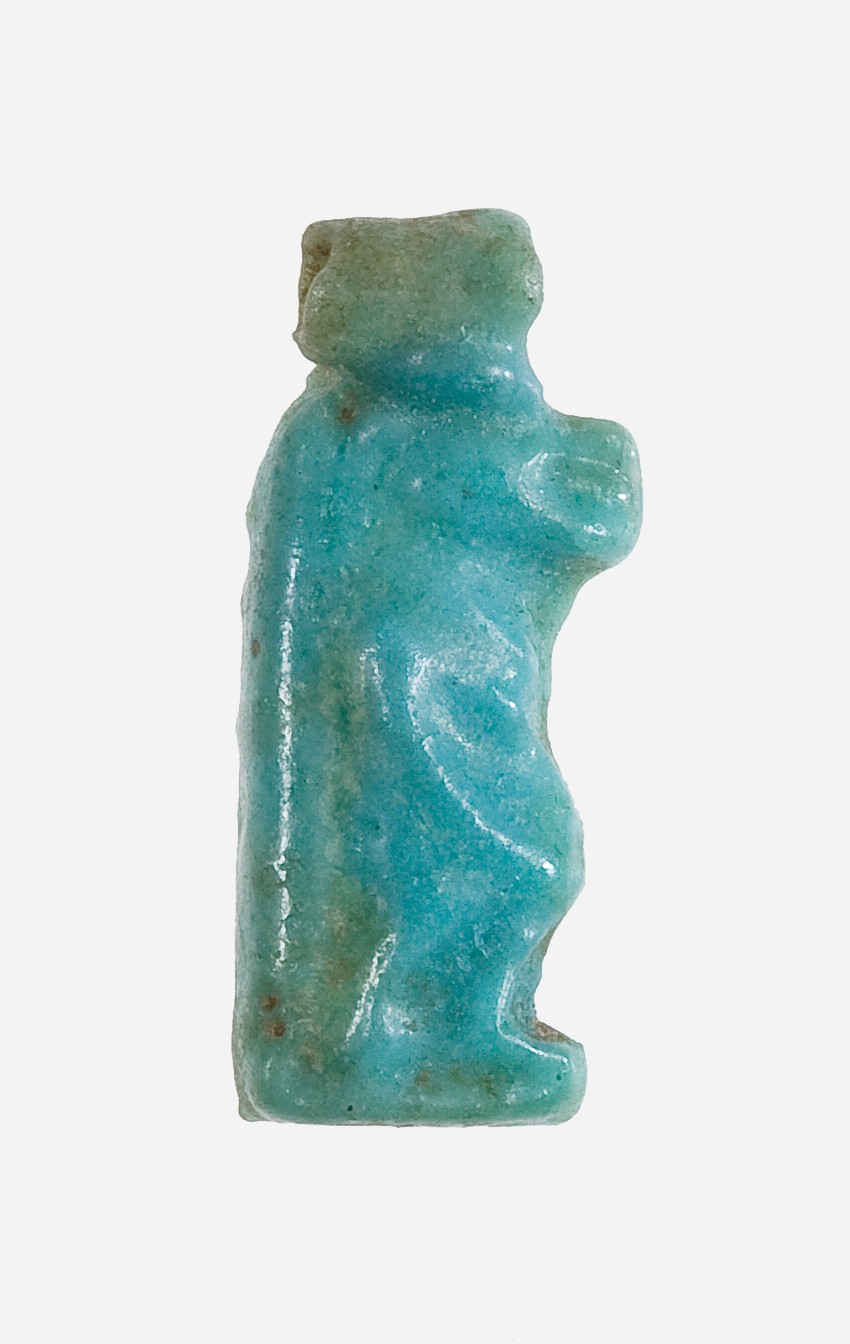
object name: amulet, taweret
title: Taweret Amulet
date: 1390-1352 BCE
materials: faience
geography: egypt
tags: taweret